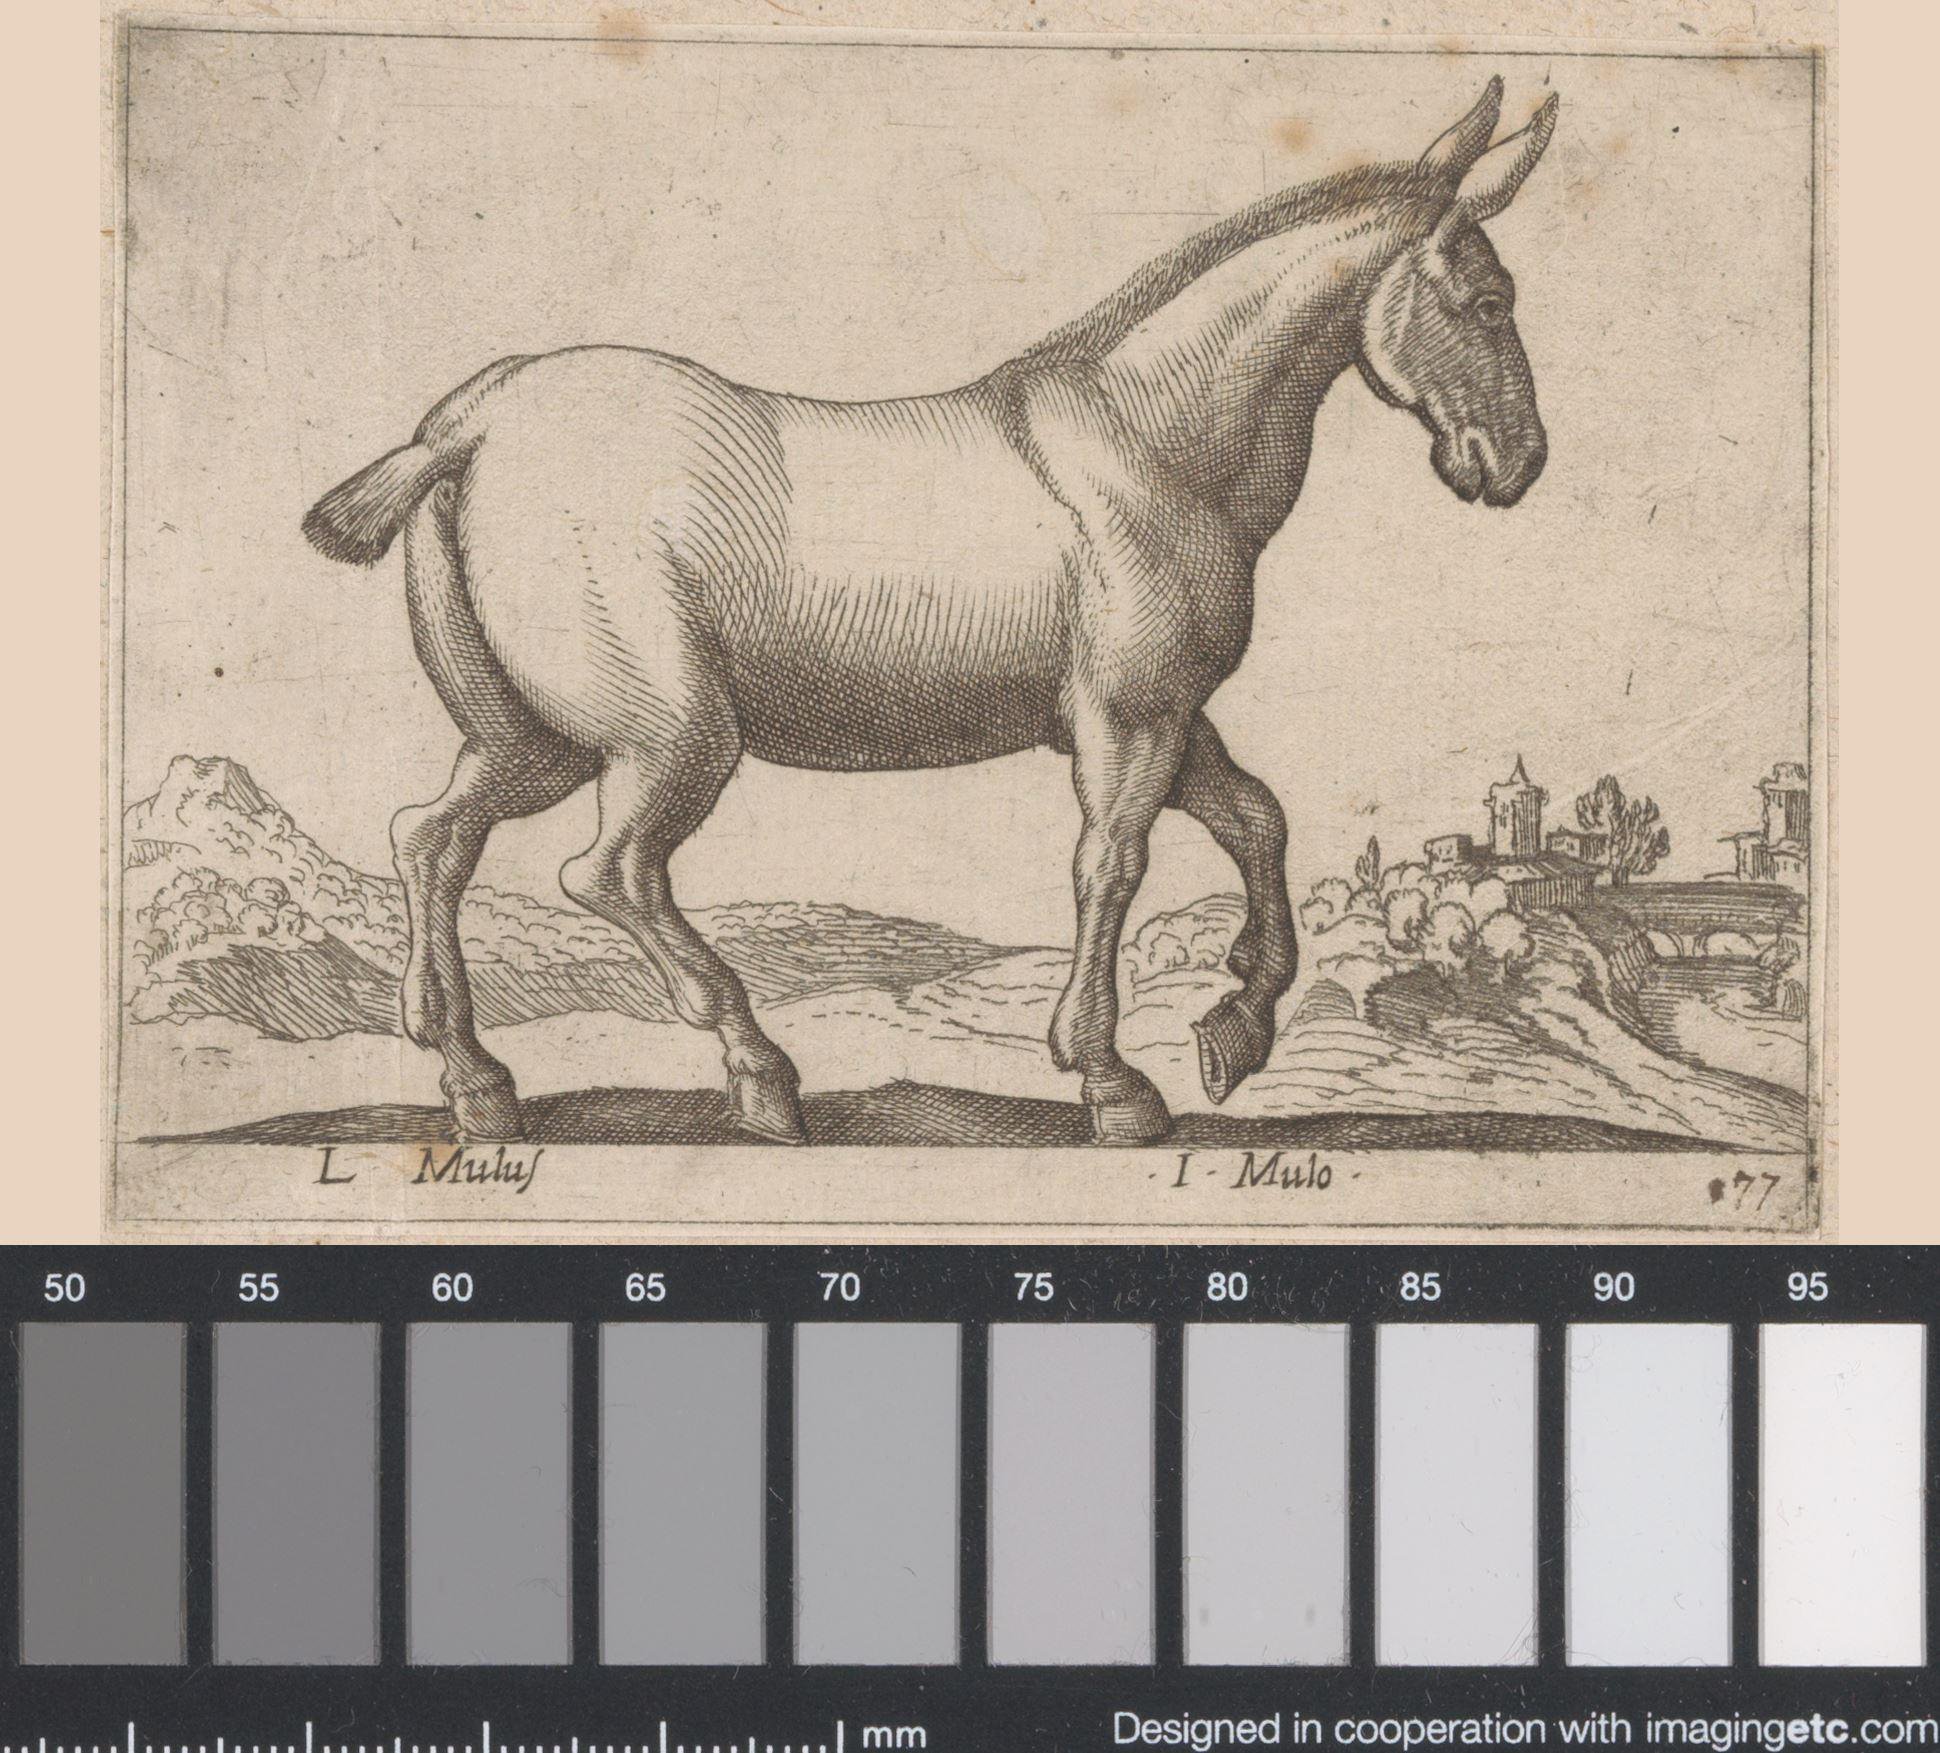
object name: print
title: Nova raccolta de li animali piu curiosi del mondo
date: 1565-1630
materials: paper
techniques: etching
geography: vatican city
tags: mule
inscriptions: collector's mark: Lugt 11, number: ‘177’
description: Deze prent maakt deel uit van een reeks prenten van dieren door Antonio Tempesta. Bekend is dat een tweede staat (met nummering) van deze serie is uitgegeven door Giovanni Giacomo de' Rossi in 1650. Onbekend is wie de eerste staat heeft uitgegeven en wanneer.